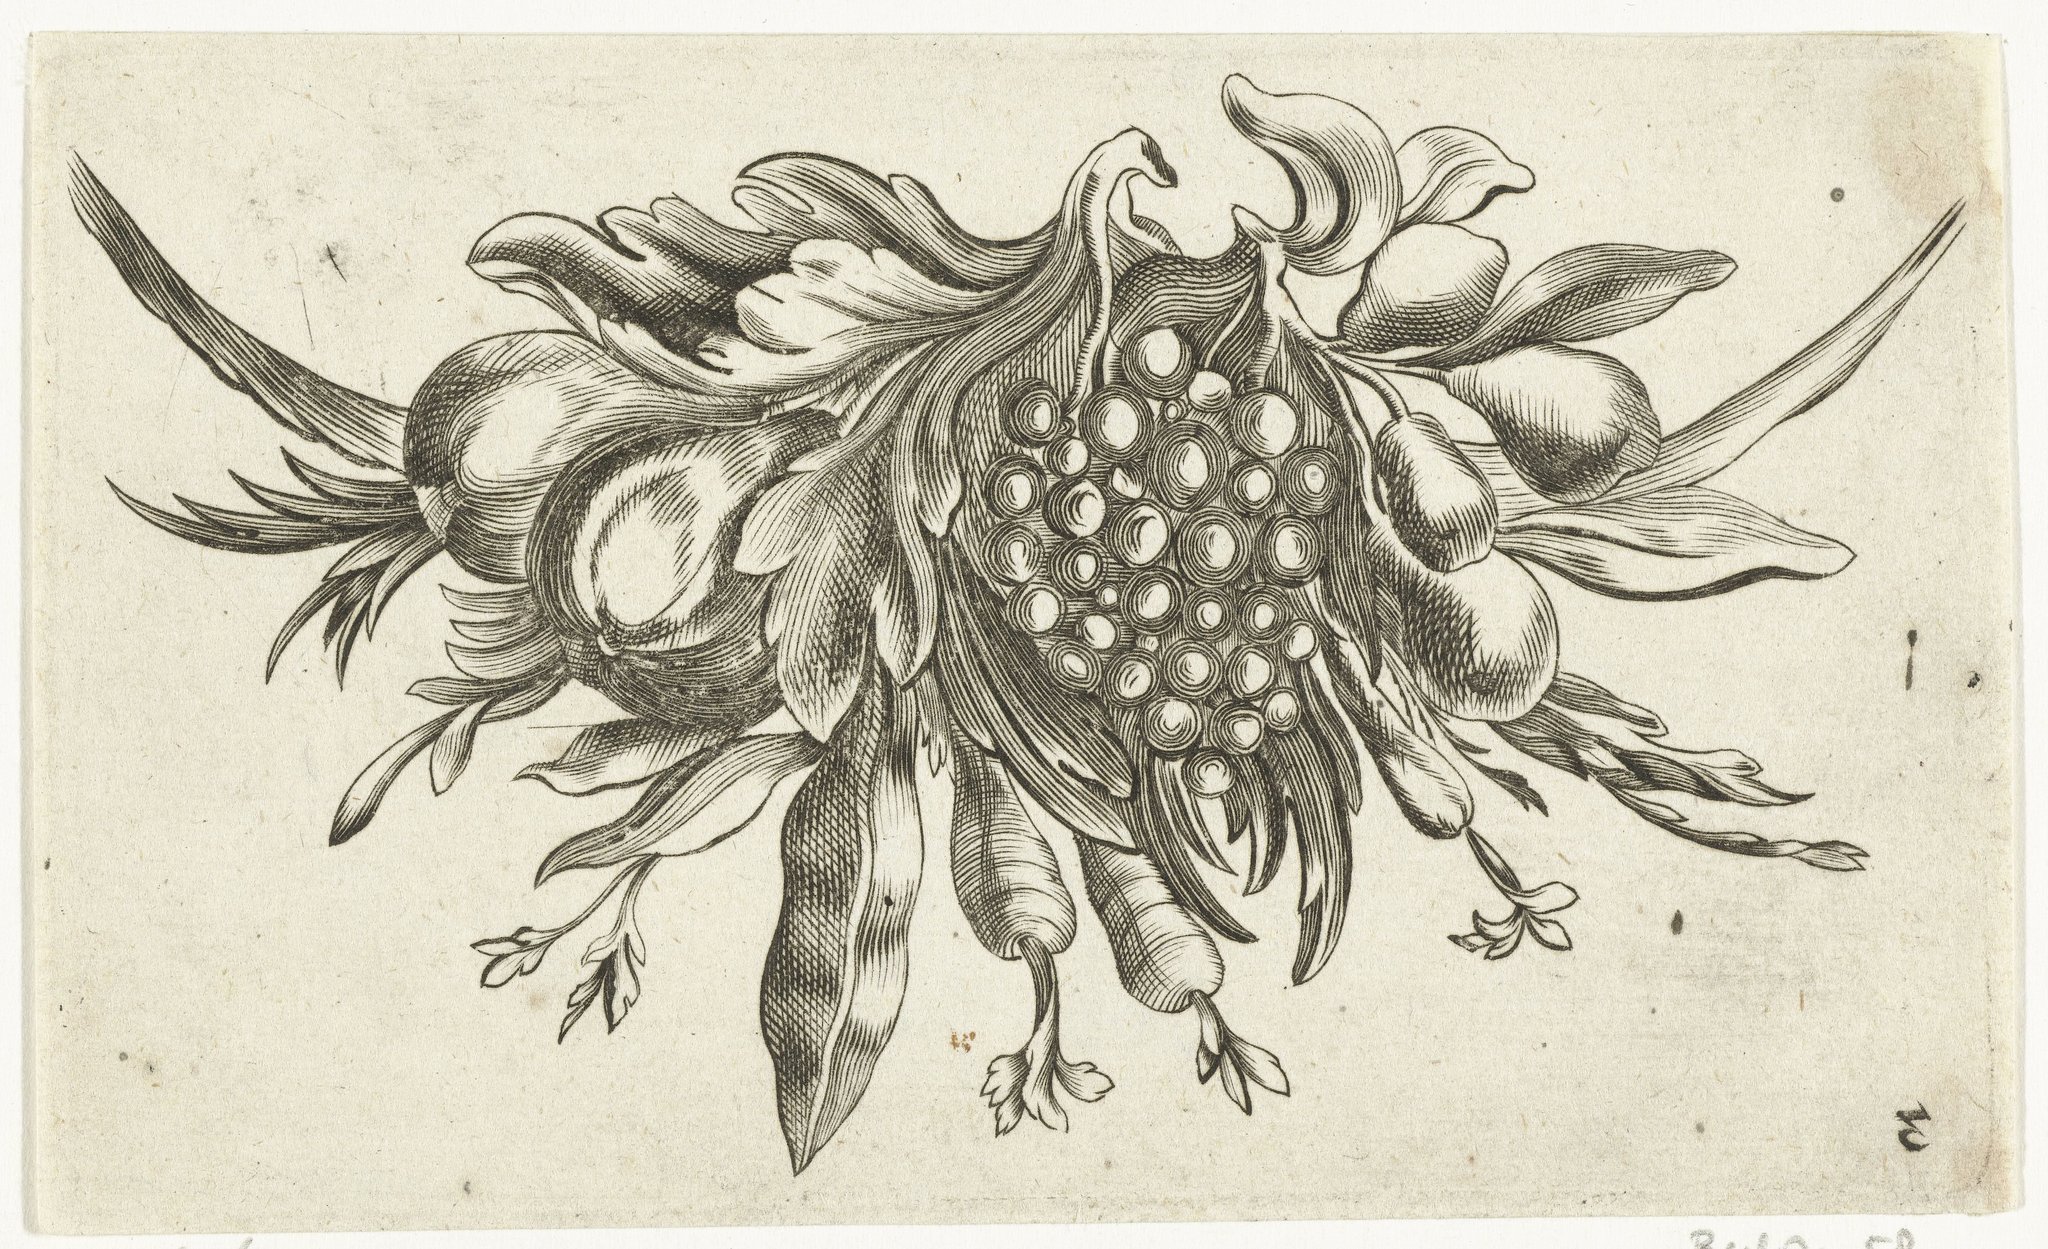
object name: print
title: Bundel fruit met peren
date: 1654-1677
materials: paper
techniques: engraving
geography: germany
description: Tussen het fruit hangen een druiventros en drie wortels.